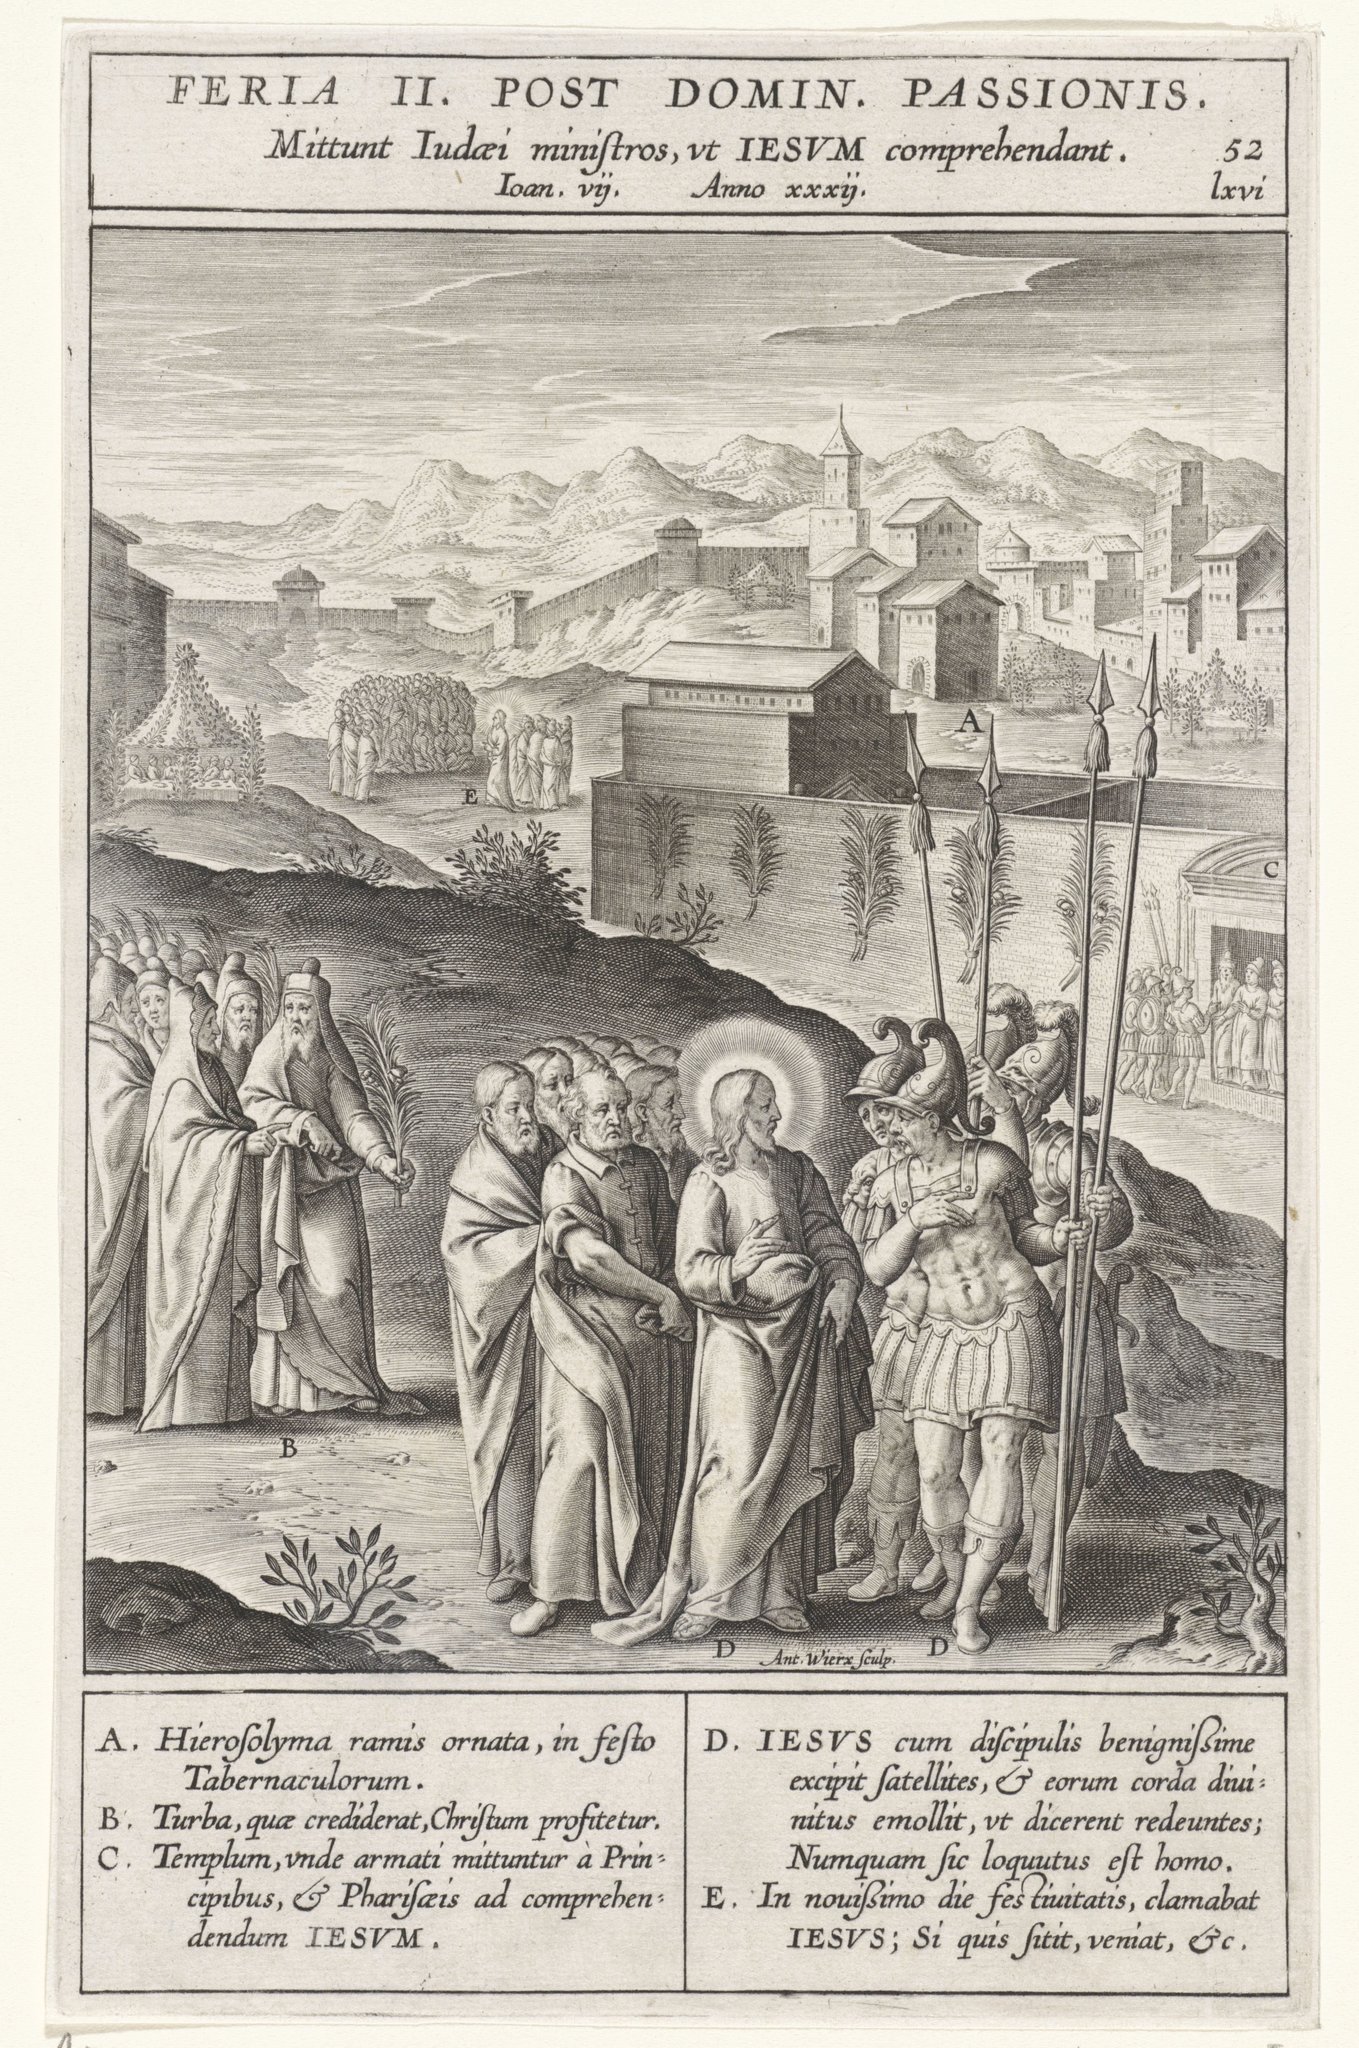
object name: print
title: Feria II. Post Domin. Passionis.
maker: antonie wierix (ii)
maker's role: draughtsman, print maker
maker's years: 1555-1604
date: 1593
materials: paper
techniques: engraving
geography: antwerp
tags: pharisees and chief priests conspire against christ on the feast of the tabernacles in jerusalem (john 7:32, 7:45-53)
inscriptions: collector's mark: Lugt 2165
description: Christus te midden van de dienaren die door de farizeeën en de hogepriesters zijn gestuurd om hem te arresteren. Omdat er verdeeldheid was ontstaan in de menigte doet niemand iets. Bij verschillende elementen uit de voorstelling staan letters die corresponderen met de legenda in de marge.